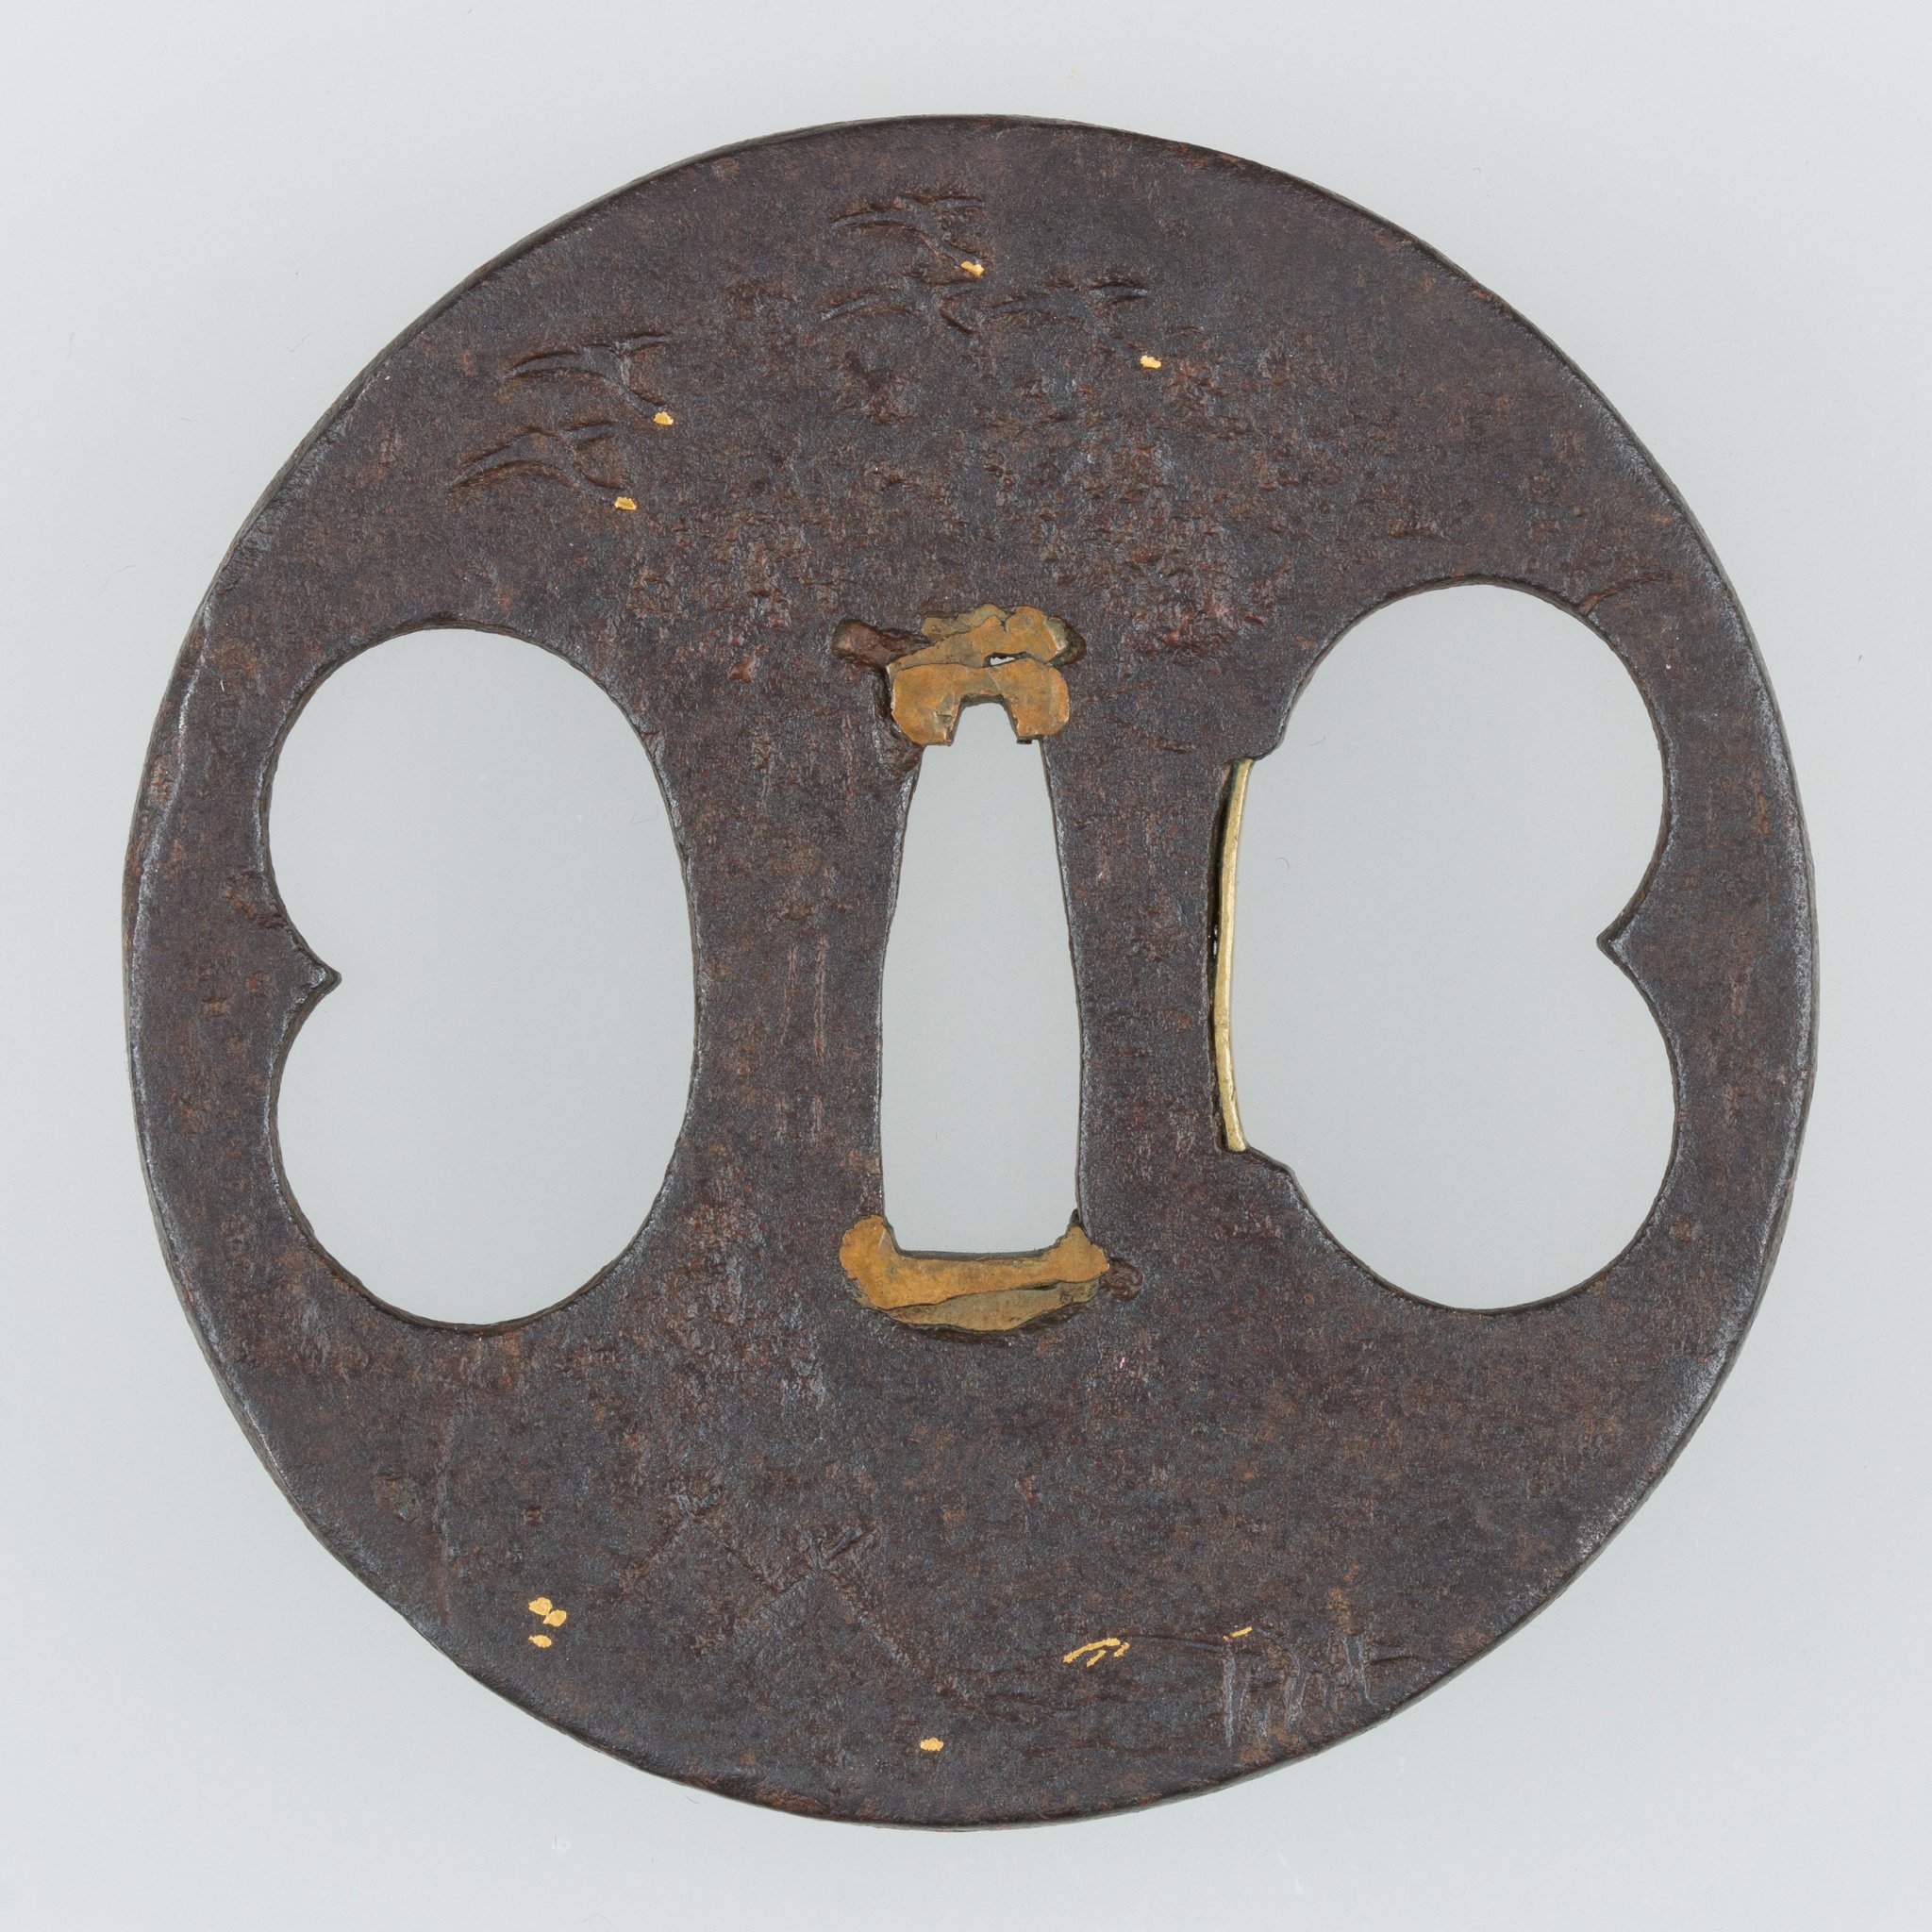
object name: sword guard tsuba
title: Sword Guard (Tsuba)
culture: japanese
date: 1501-1900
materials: gold, iron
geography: japan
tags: birds